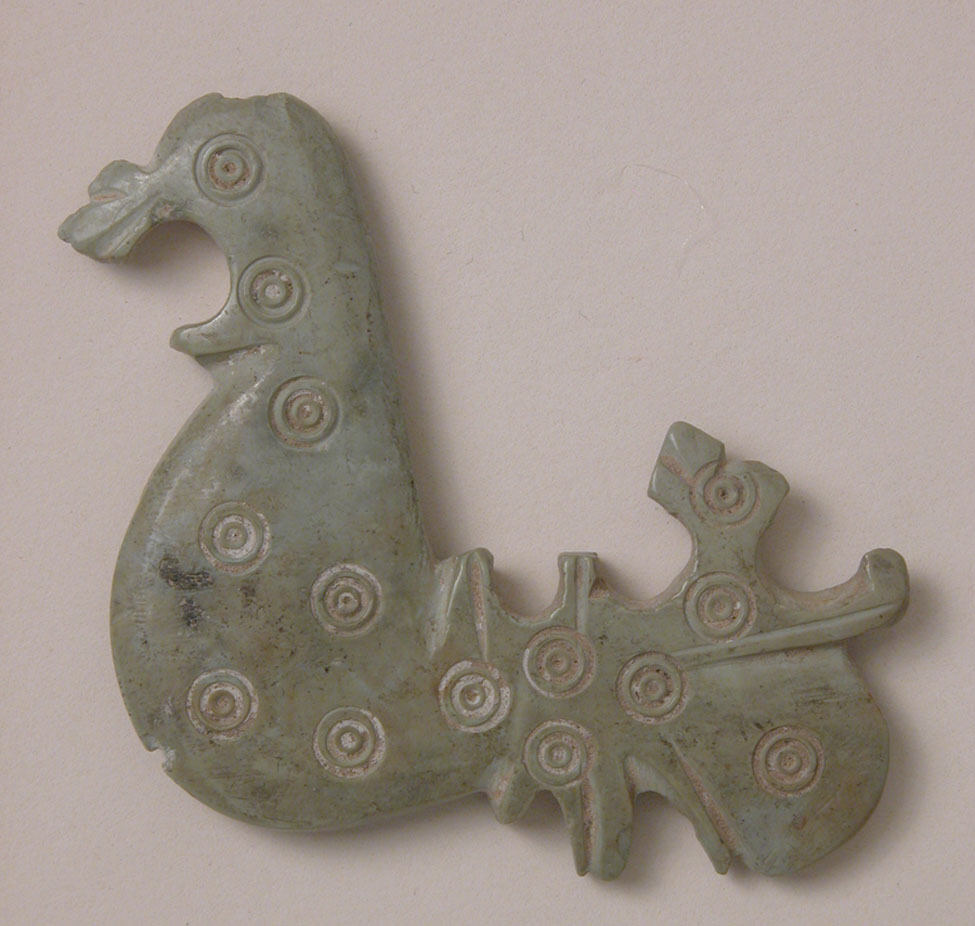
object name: kohl flask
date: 801-1000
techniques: carving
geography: iran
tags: birds